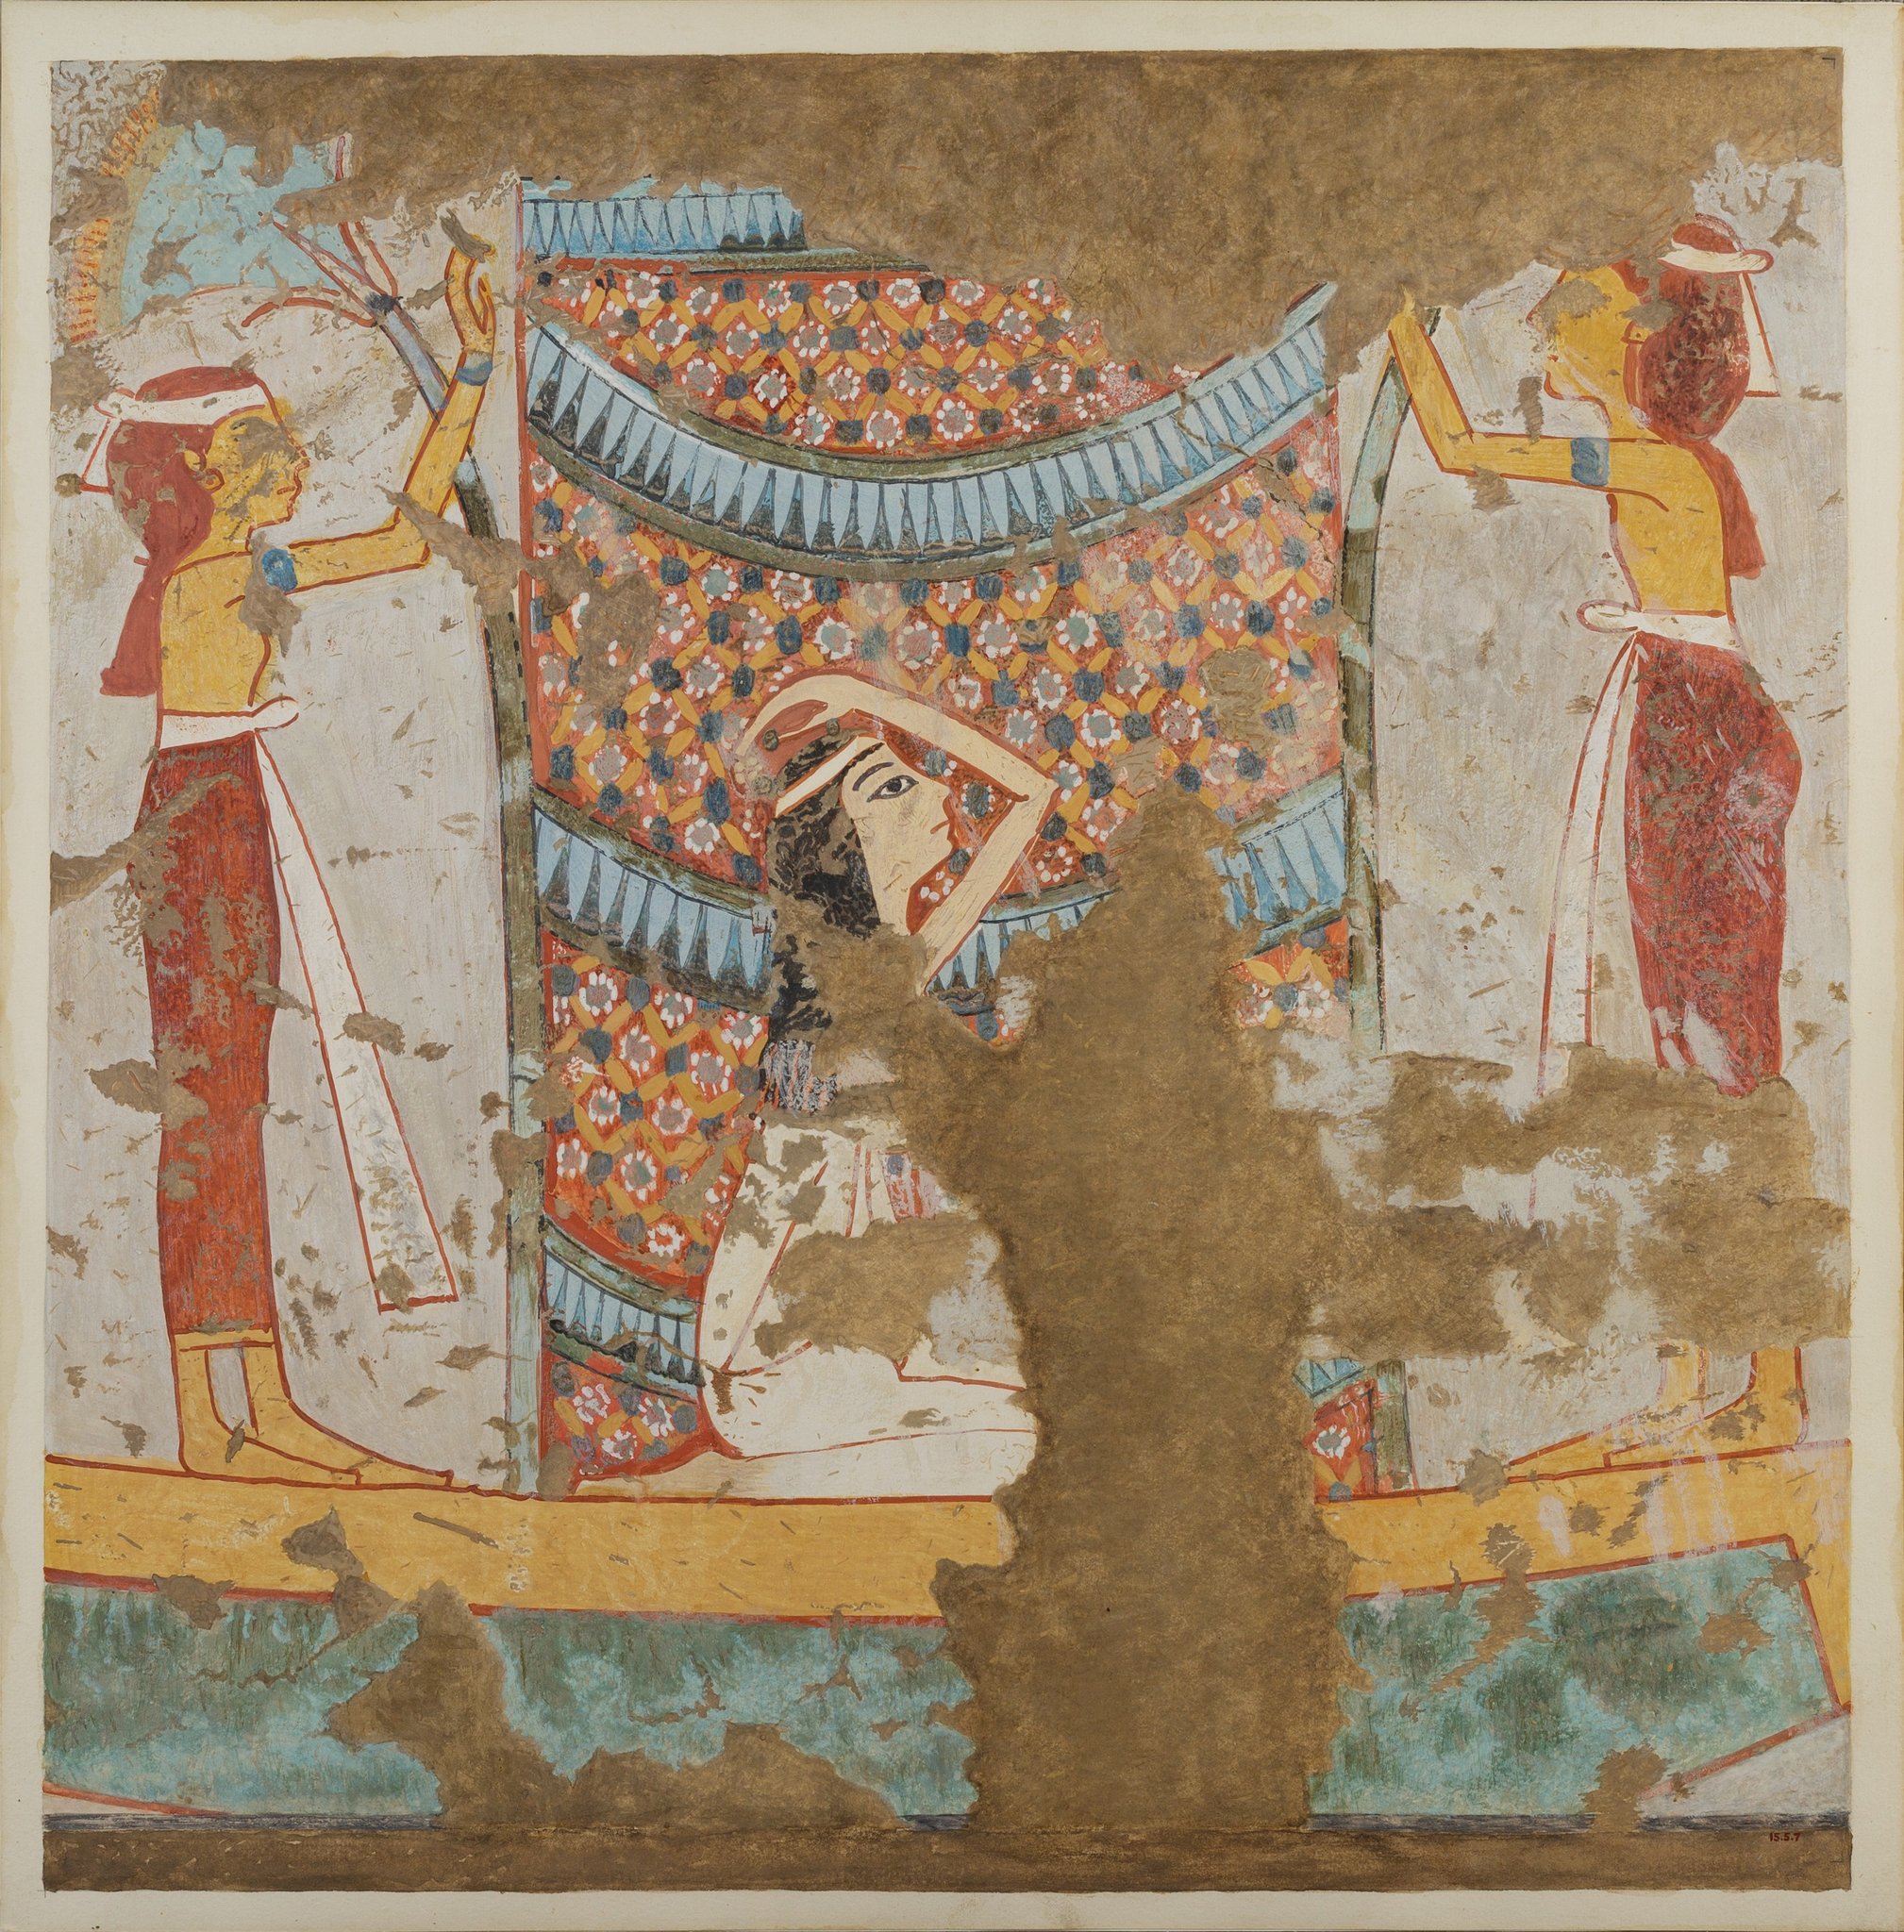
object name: facsimile, haremhab tt 207, mourning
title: Funeral Boat, Tomb of Haremhab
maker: norman de garis davies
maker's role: artist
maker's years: 1865-1941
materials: paper, paint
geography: egypt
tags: women,boats